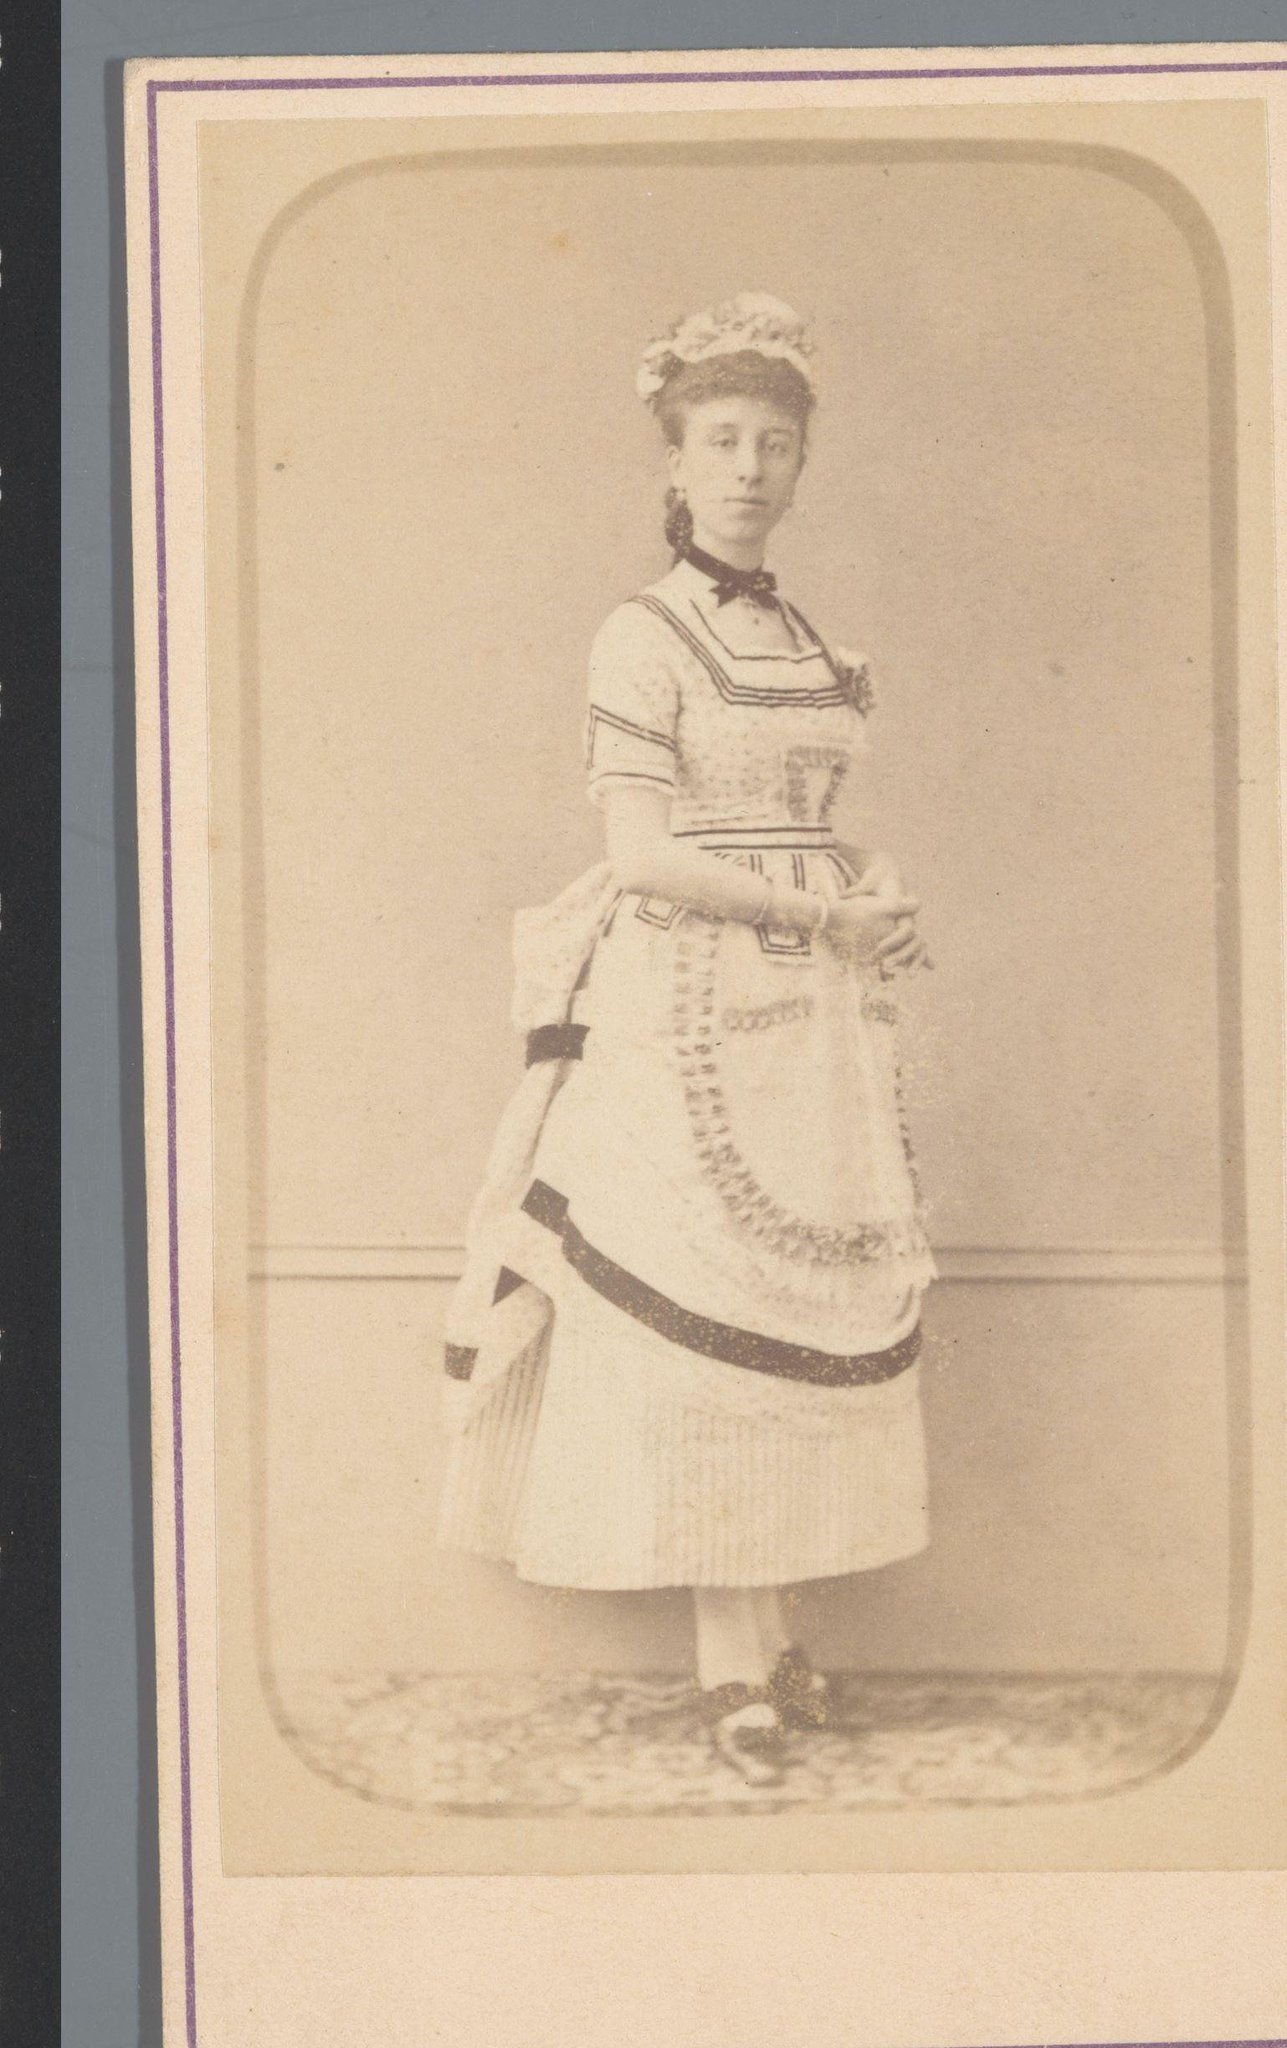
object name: carte de visite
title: Portret van een onbekende jonge vrouw, mogelijk een dienstmeisje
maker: emile crépin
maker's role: fotograaf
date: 1855-1885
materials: cardboard, paper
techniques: albumen print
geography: paris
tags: adolescent, young woman, maiden, anonymous historical person portrayed, maid ~ house personnel, paris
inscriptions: inscription: ‘Émile Crépin/ photographe/ 6, Rue Marengo, 6/ En face le Magasin du Louvre/ Paris’